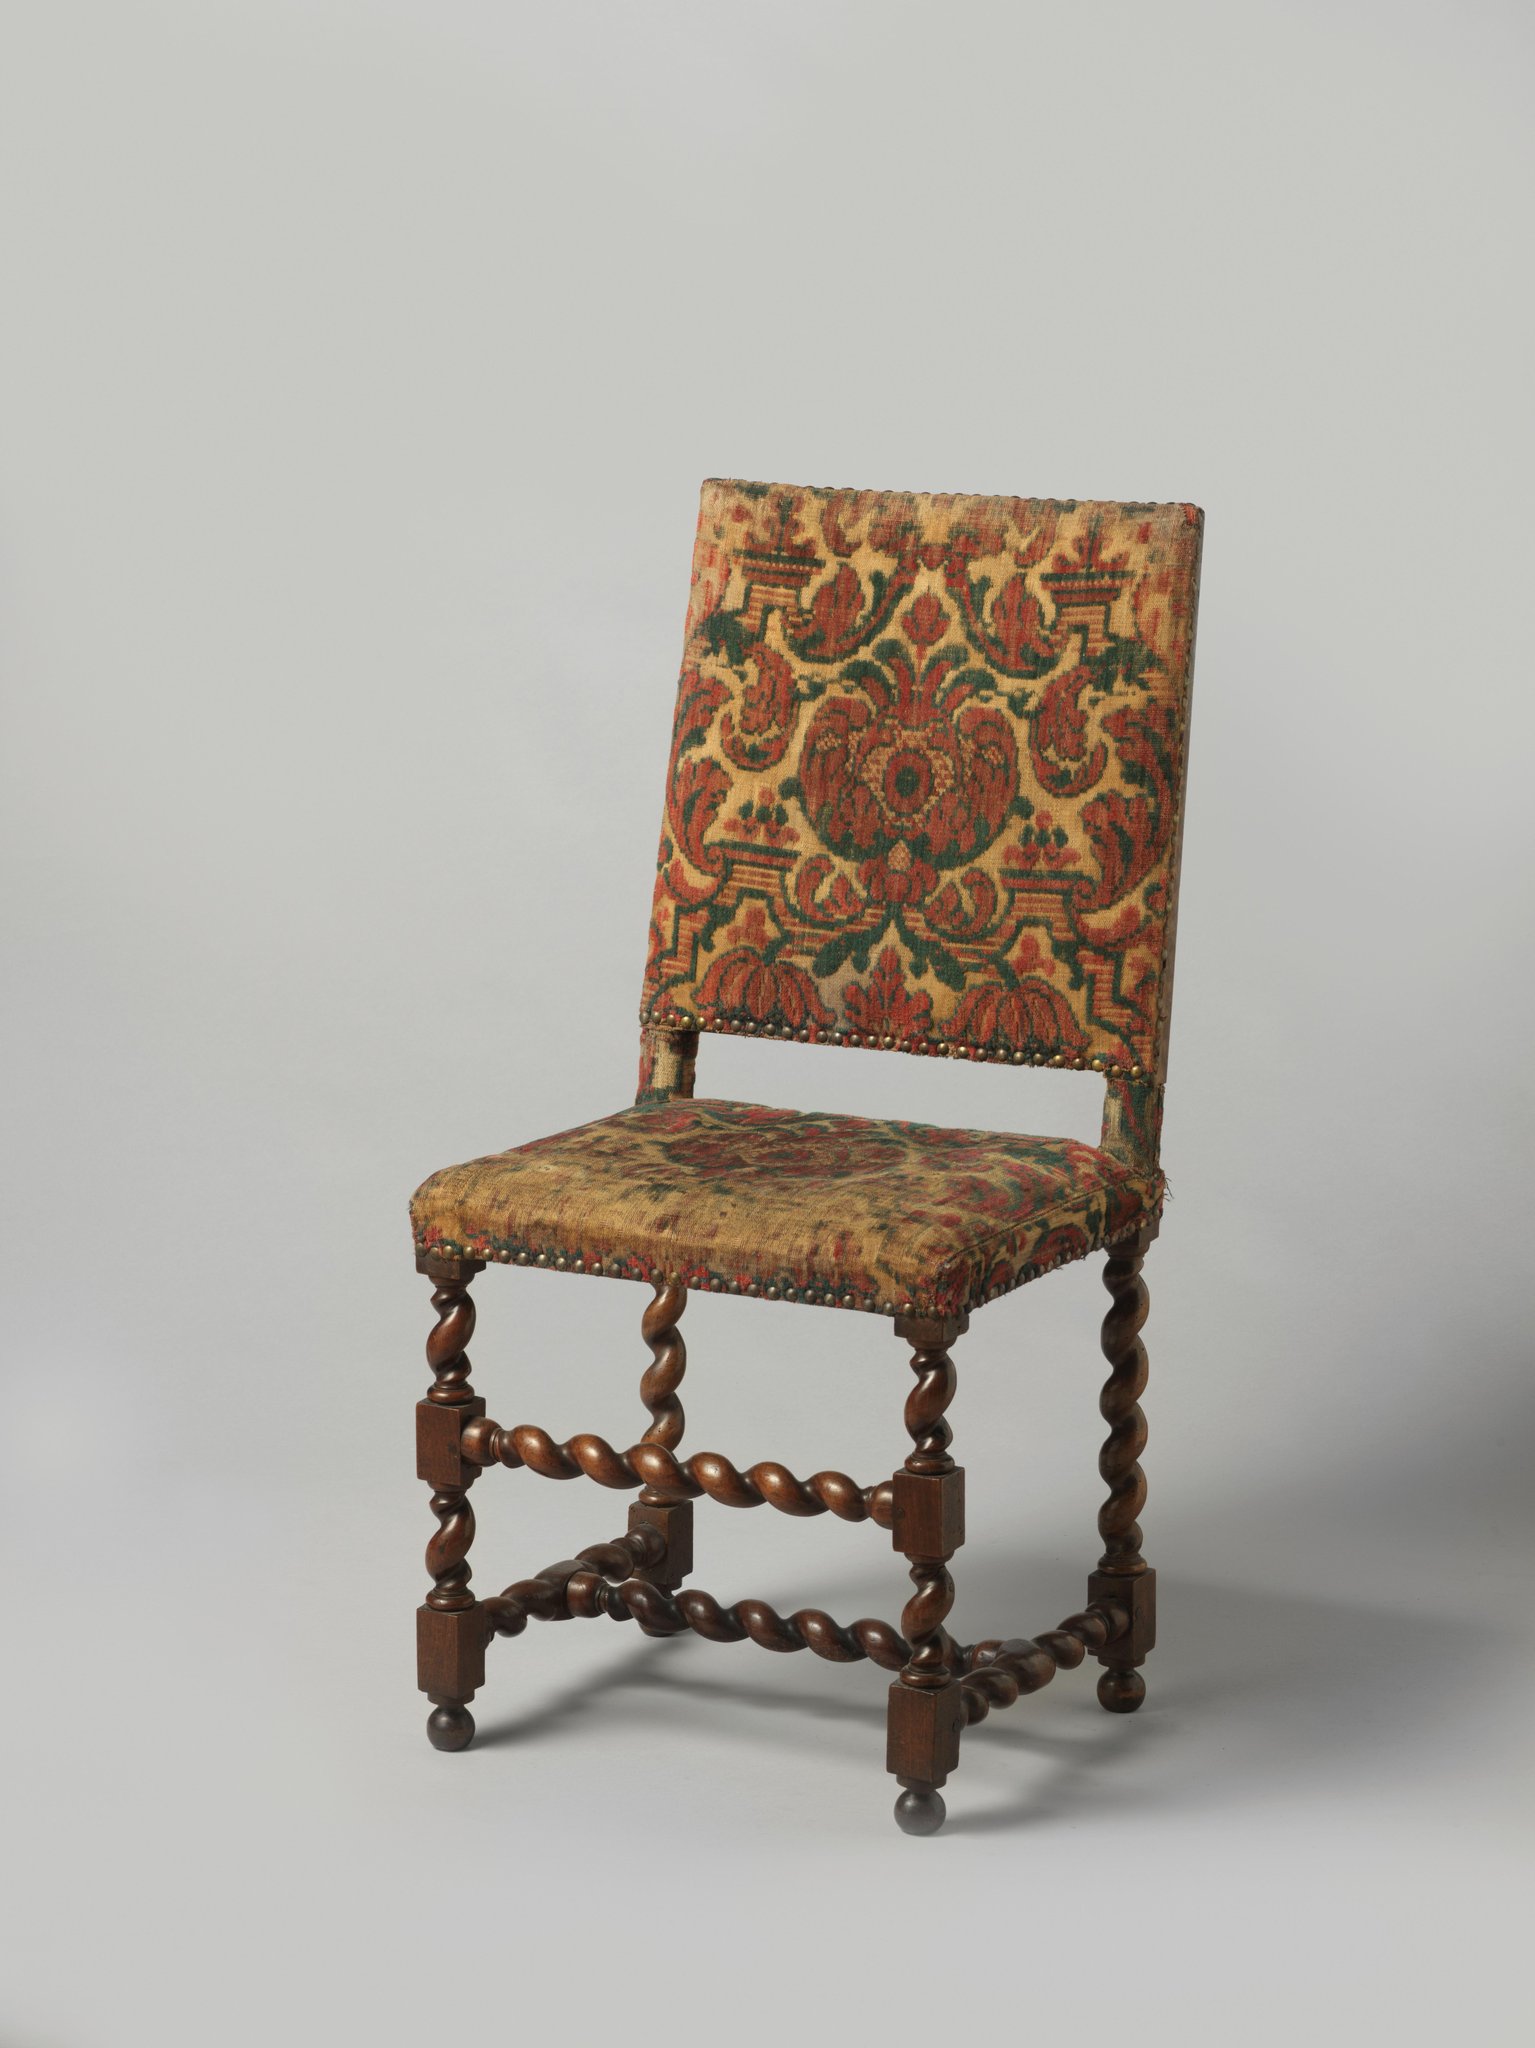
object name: furniture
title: Stoel met slingerpoten, bekleed met trijp met een patroon van rode en groene granaten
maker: Anonymous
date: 1650-1700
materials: textile, velvet, wood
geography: northern netherlands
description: Stoel van notenhout, bekleed met trijp. De stoel heeft geslingerde poten, die door een H-vormig kruis en een middensport, alle eveneens geslingerd, verbonden zijn. Het trijp vertoont een patroon van rode en groene granaten op een grond van geschoren pool. De franje heeft kleine opstaande kwastjes boven een franjehoofd. De achterstijlen zijn omkleed. Eén uit een serie van drie stoelen (inv.nr. BK-KOG-1443-a t/m -c).